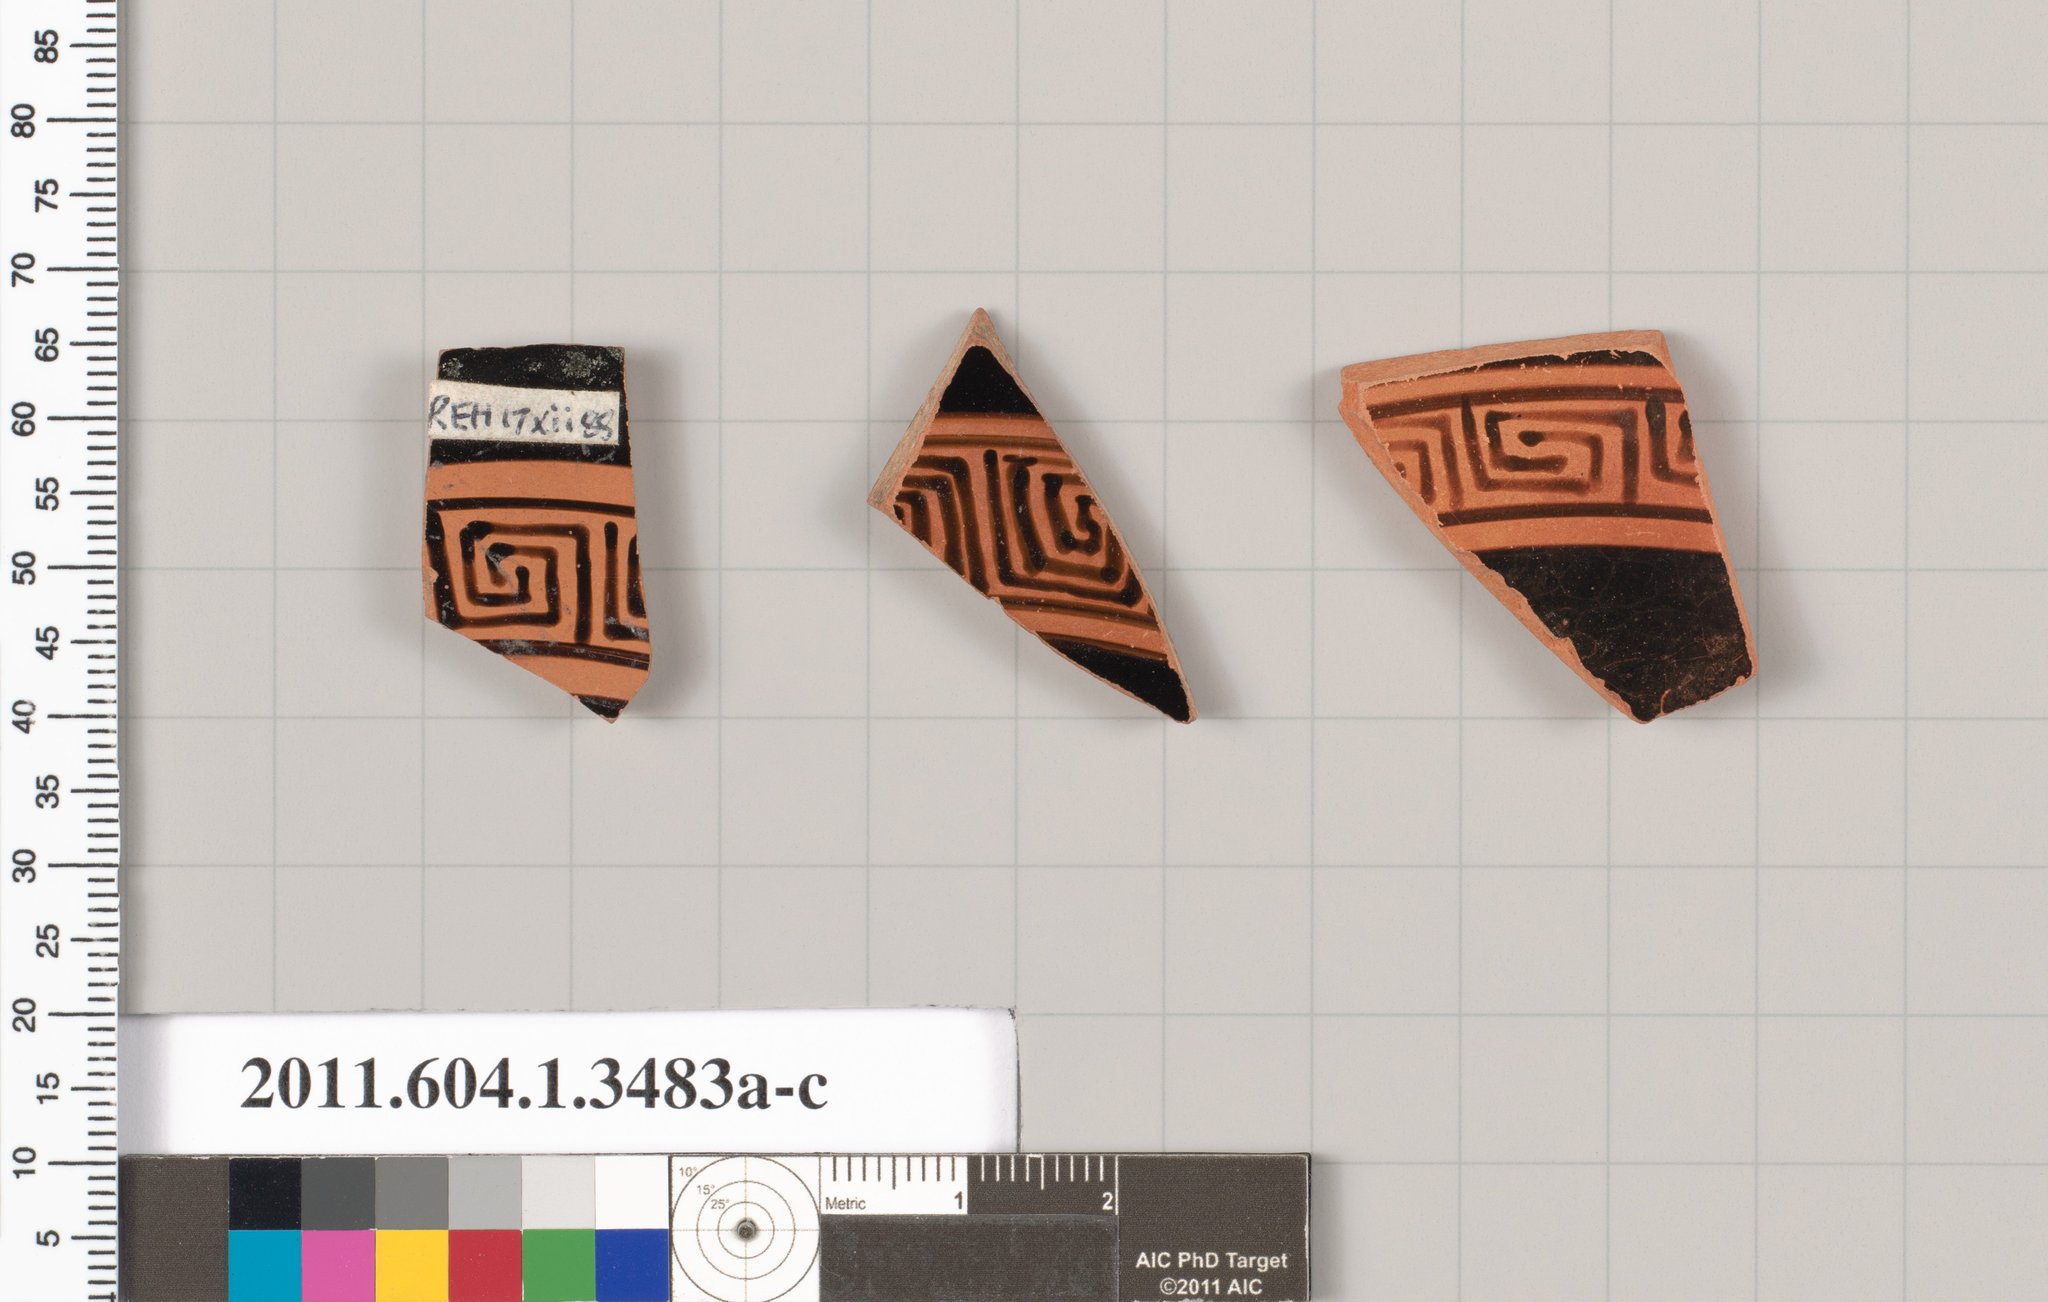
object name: kylix fragment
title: Terracotta fragments of kylikes (drinking cups)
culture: greek, attic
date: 500-475 BCE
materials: terracotta